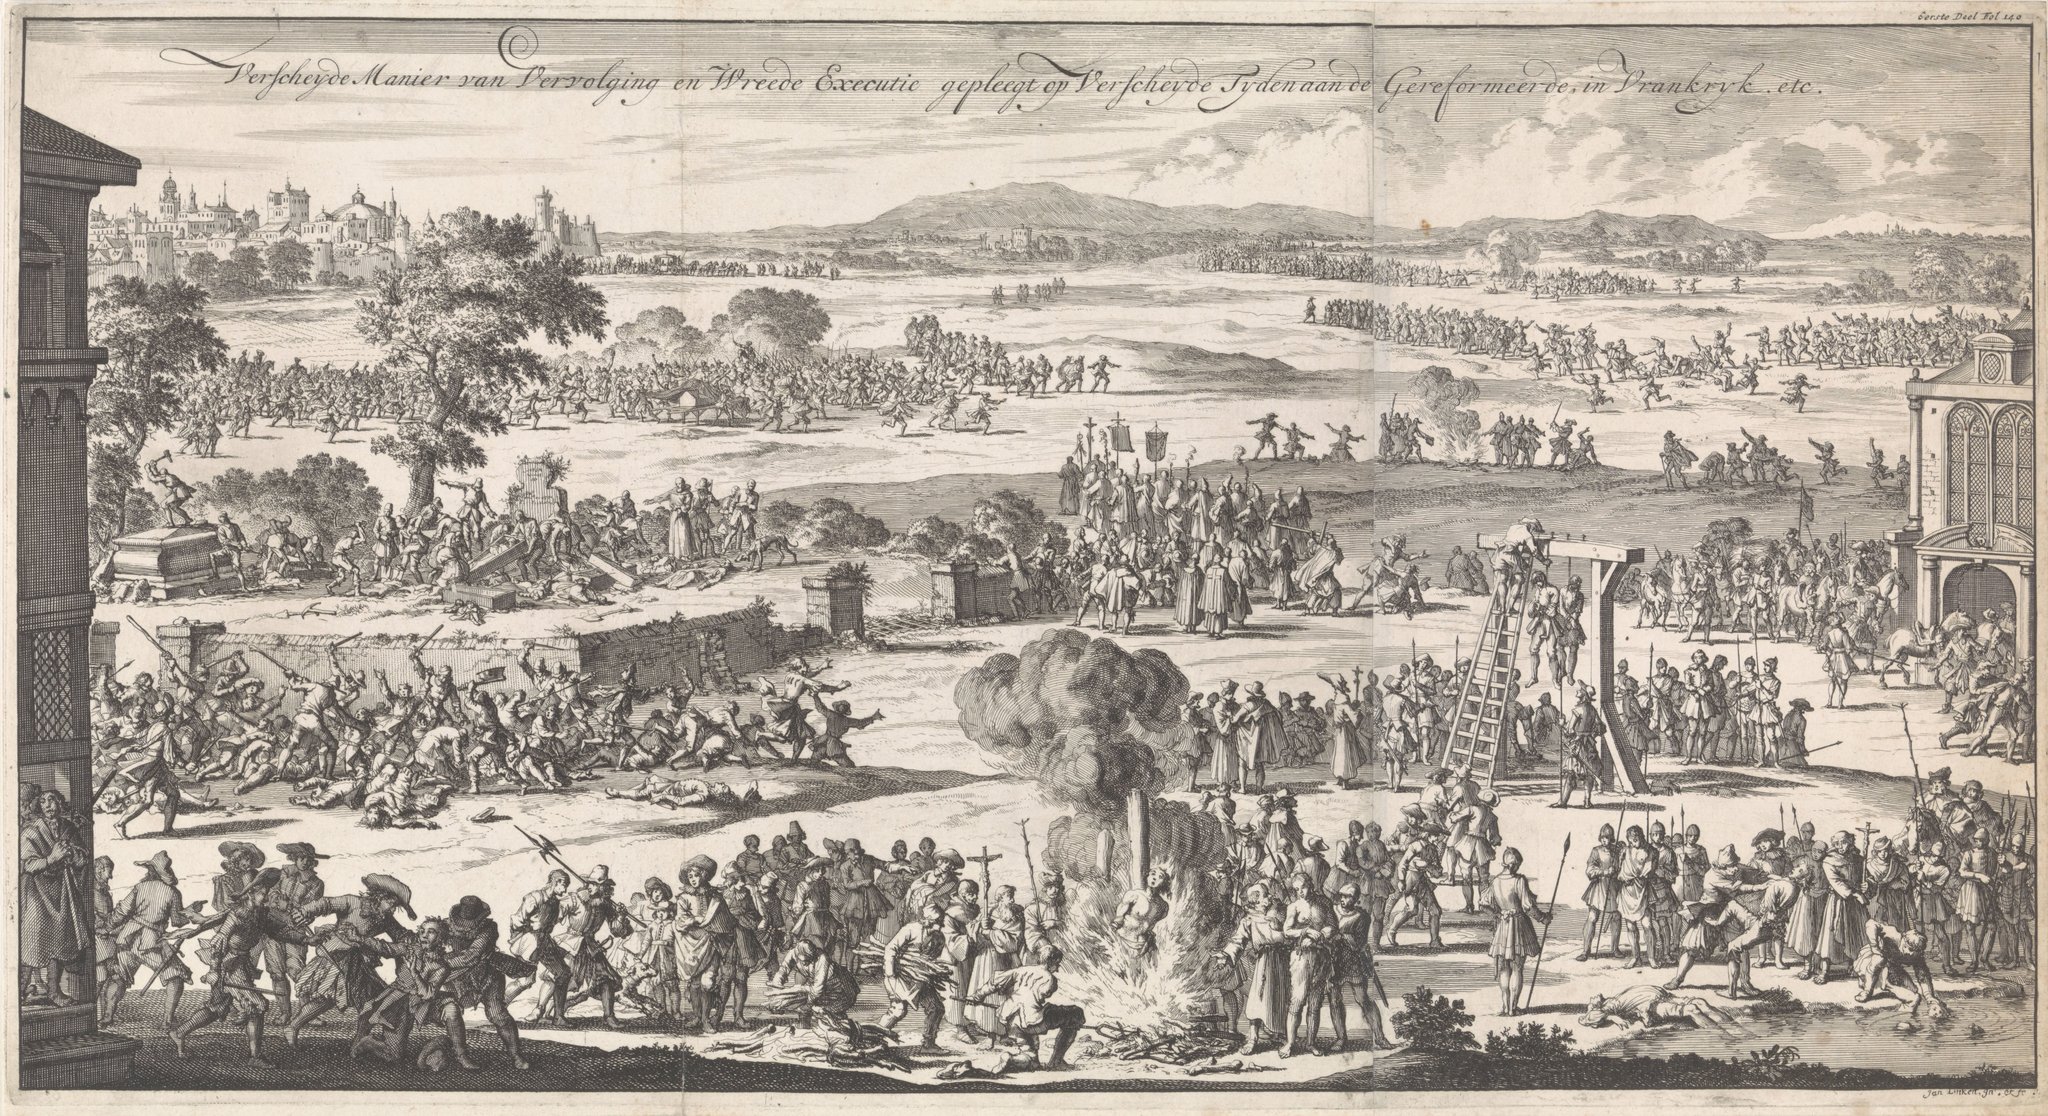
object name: book illustration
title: Verscheyde Manier van Vervolging en Wreede Executie gepleegt op Verscheyde Tyden aan de Gereformeerde, in Vrankryk. etc.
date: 1696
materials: paper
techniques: etching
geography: amsterdam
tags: violent death ~ maltreatment, torture, persecution of believers, france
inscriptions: collector's mark: Lugt 2228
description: Illustratie uit: Benoist, Elie. Historie der gereformeerde kerken van Vrankryk, 4 delen. Amsterdam: Jan Claesz ten Hoorn, 1696, dl. I.